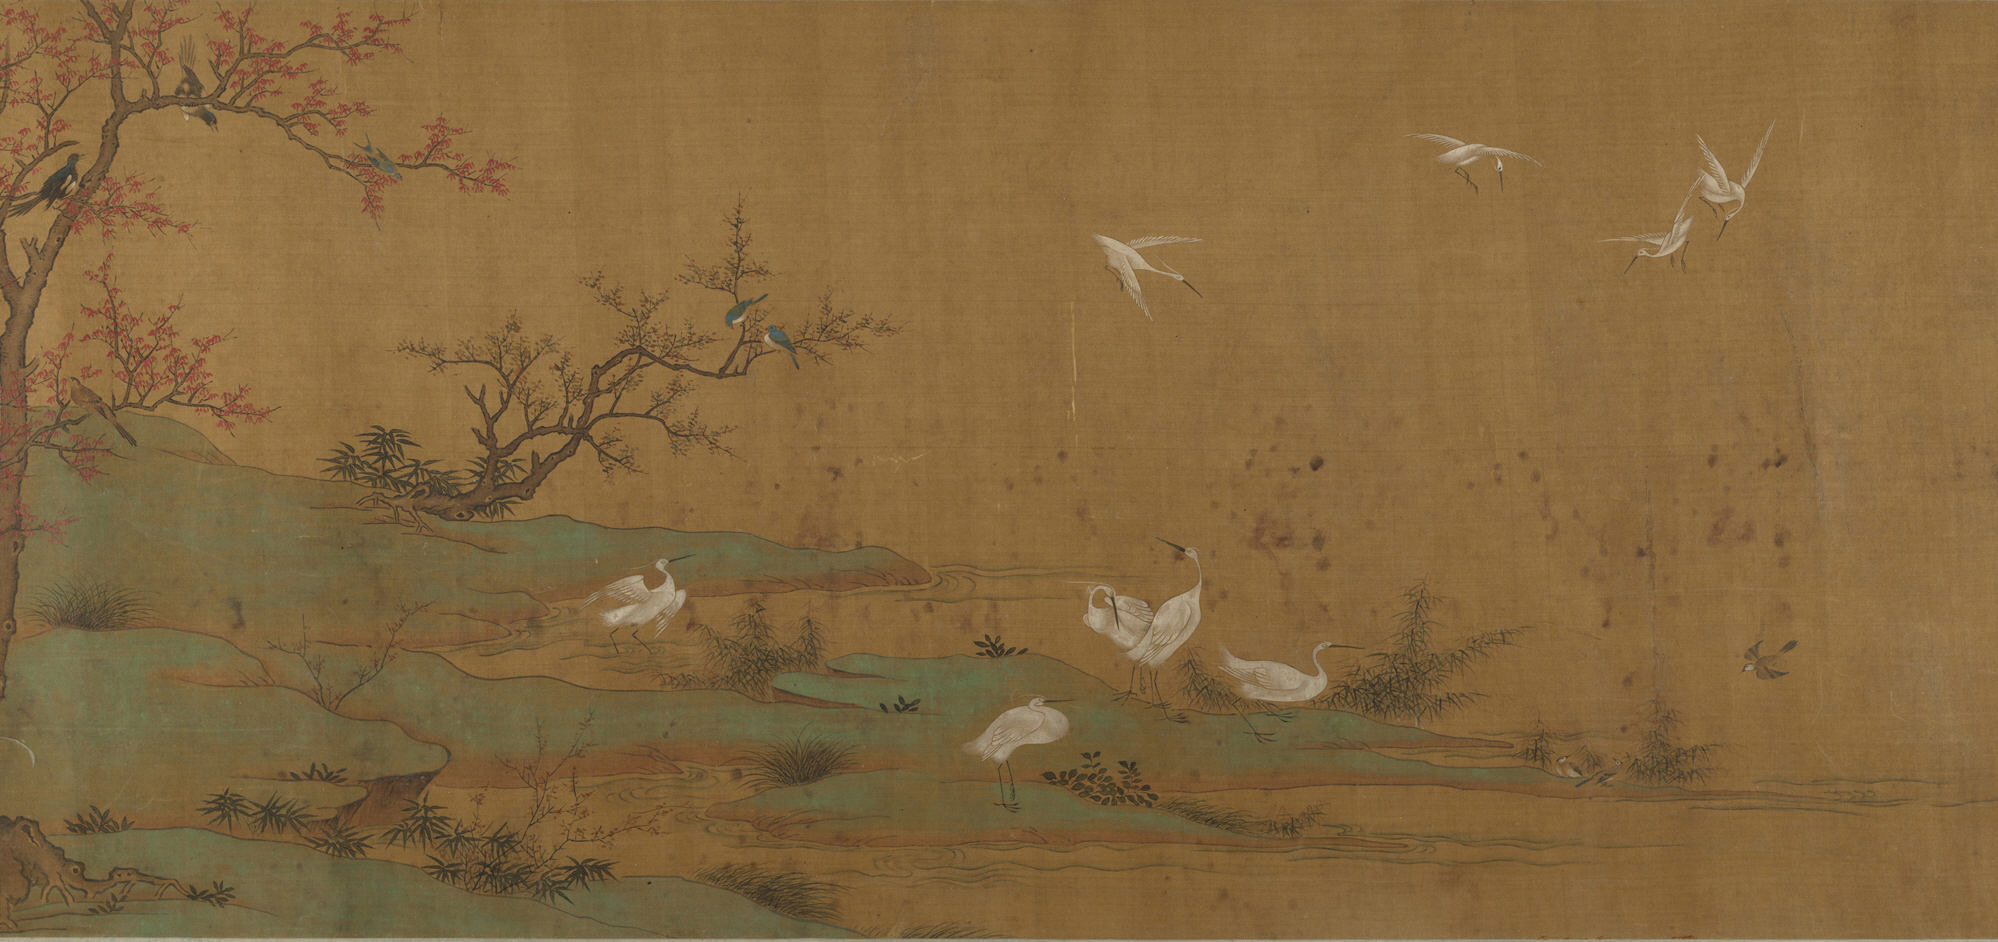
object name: handscroll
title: River Scene with Birds and Bamboo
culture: chinese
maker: unidentified artist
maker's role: artist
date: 1368-1911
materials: ink, silk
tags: birds,rivers,bamboo